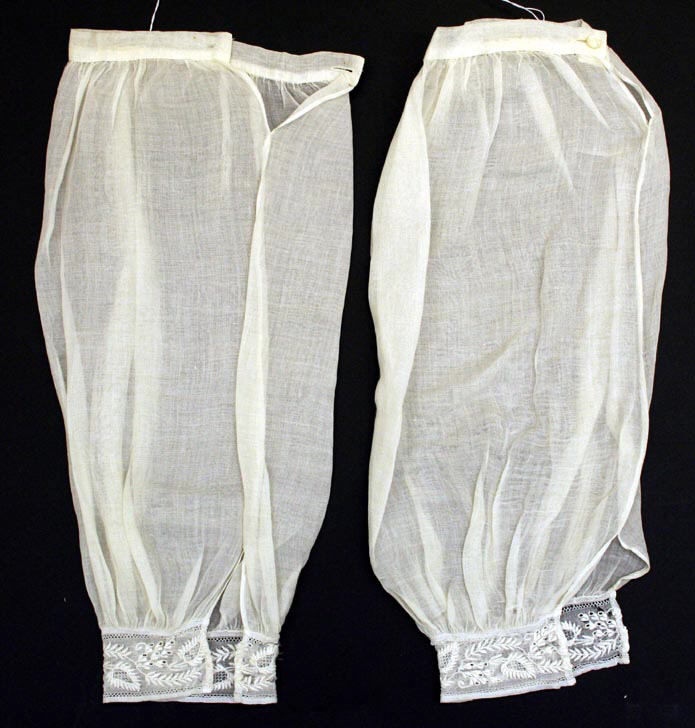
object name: undersleeves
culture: american or european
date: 1860